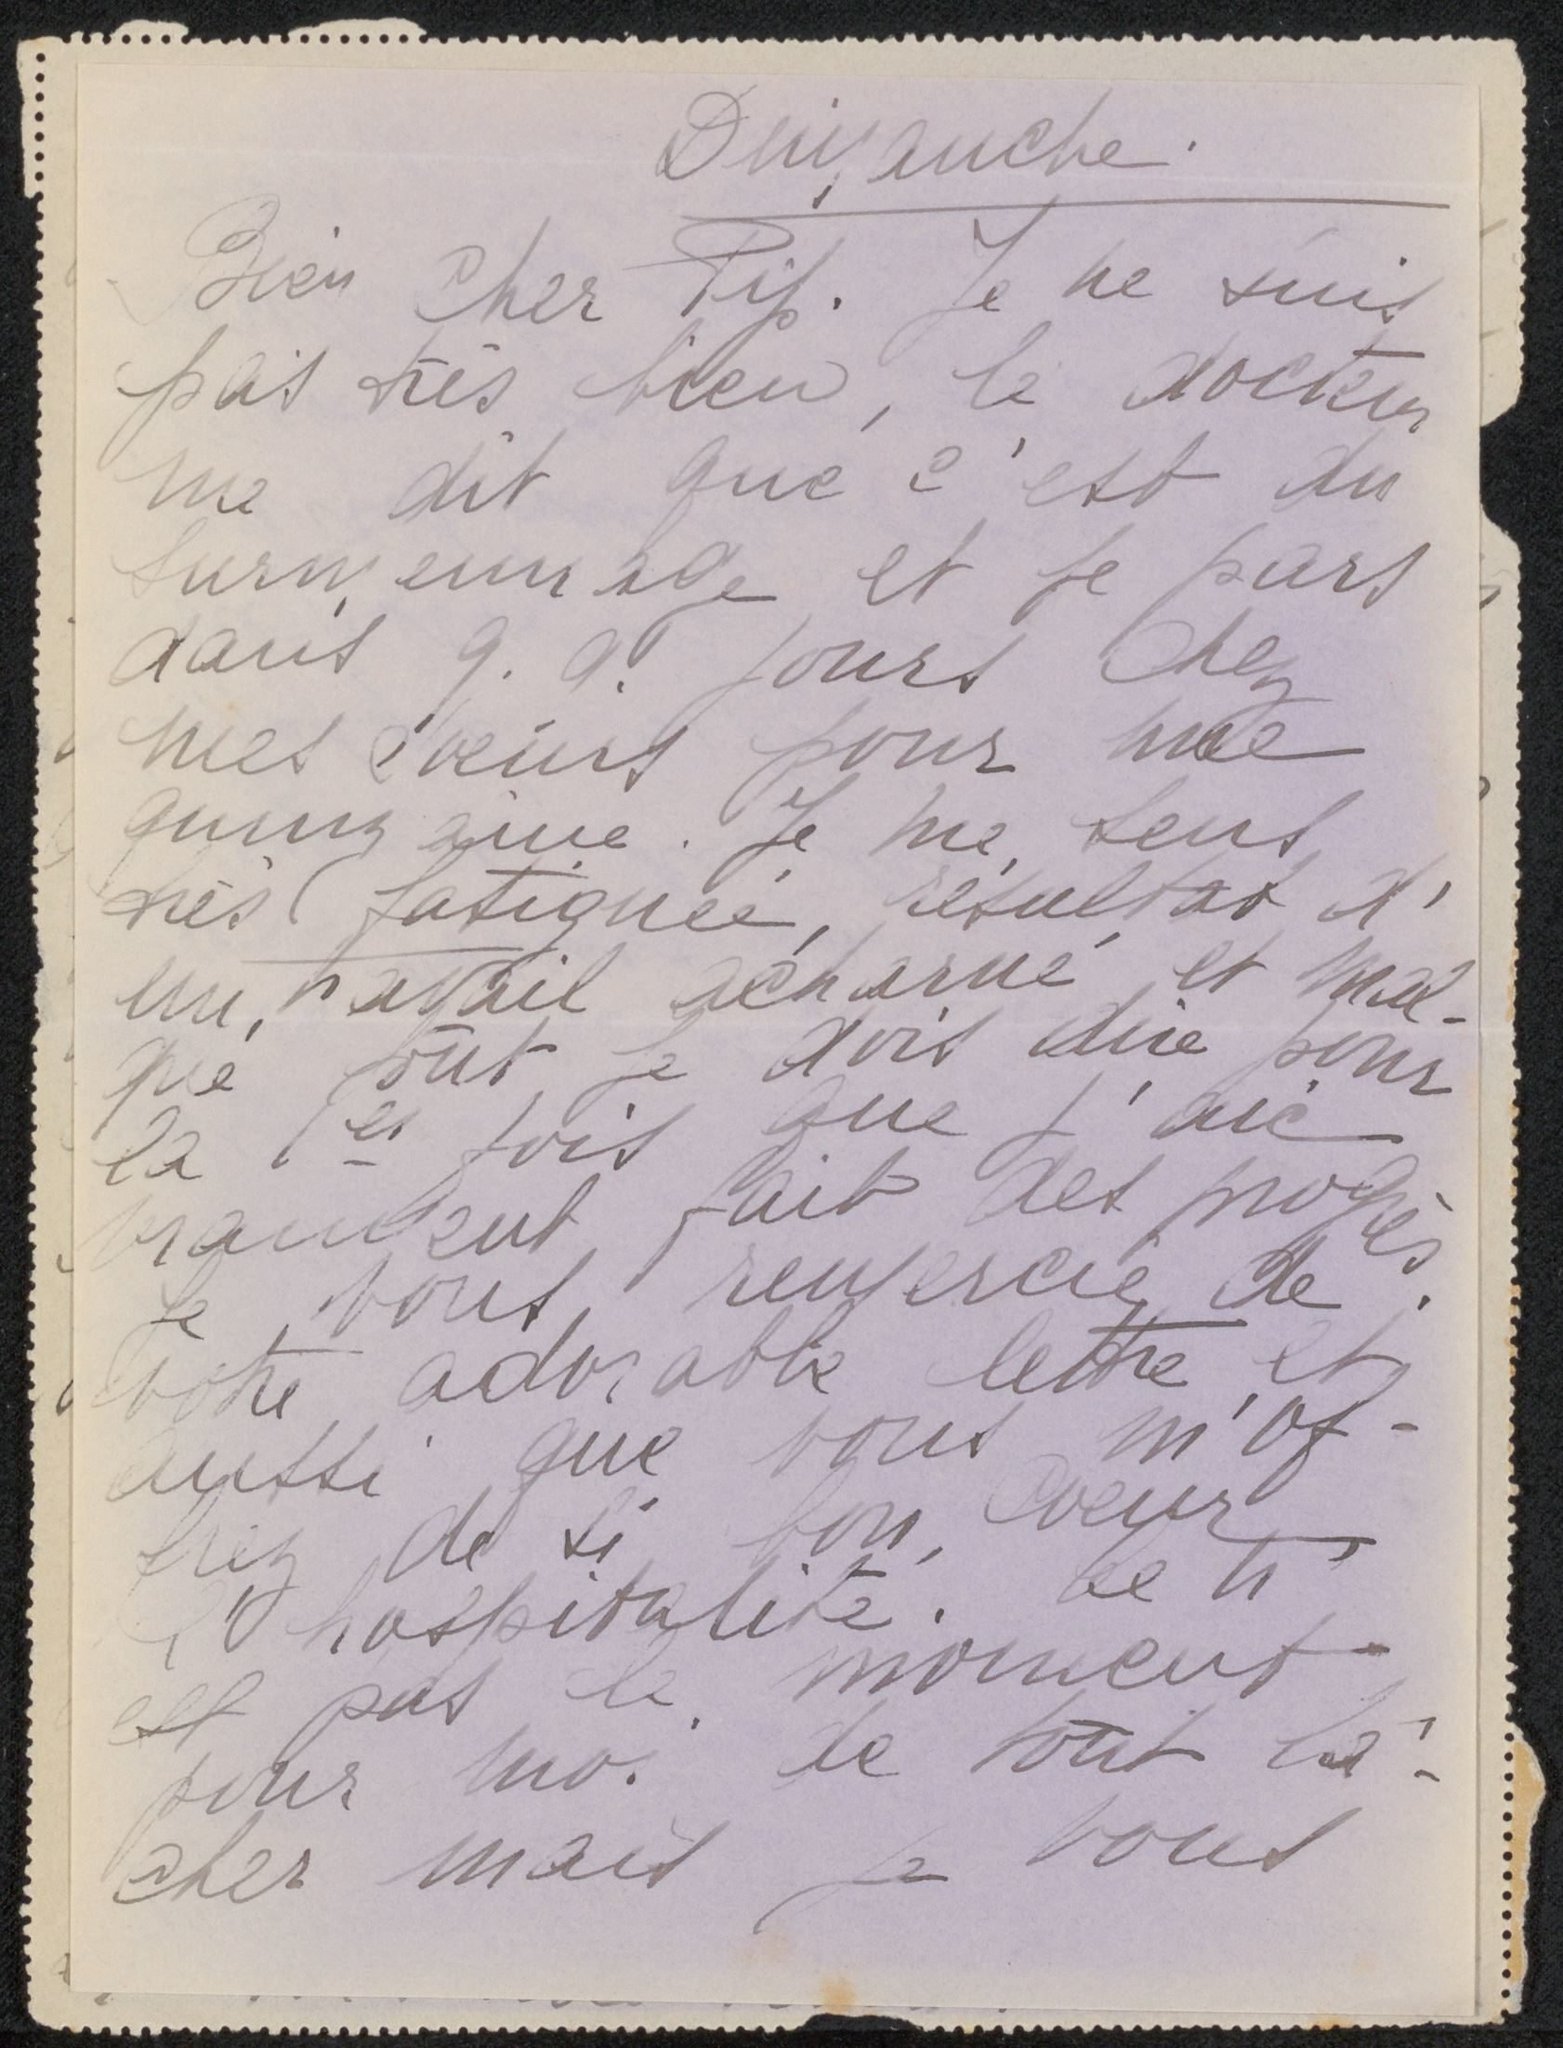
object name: letter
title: Brief aan Philip Zilcken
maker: rose imel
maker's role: draughtsman, painter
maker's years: 1901-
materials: ink, paper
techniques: pen, writing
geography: paris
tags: the hague, painter, draughtsman, philip zilcken, painting (including book-illumination, miniature-painting), diseases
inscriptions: collector's mark: ‘RPK’